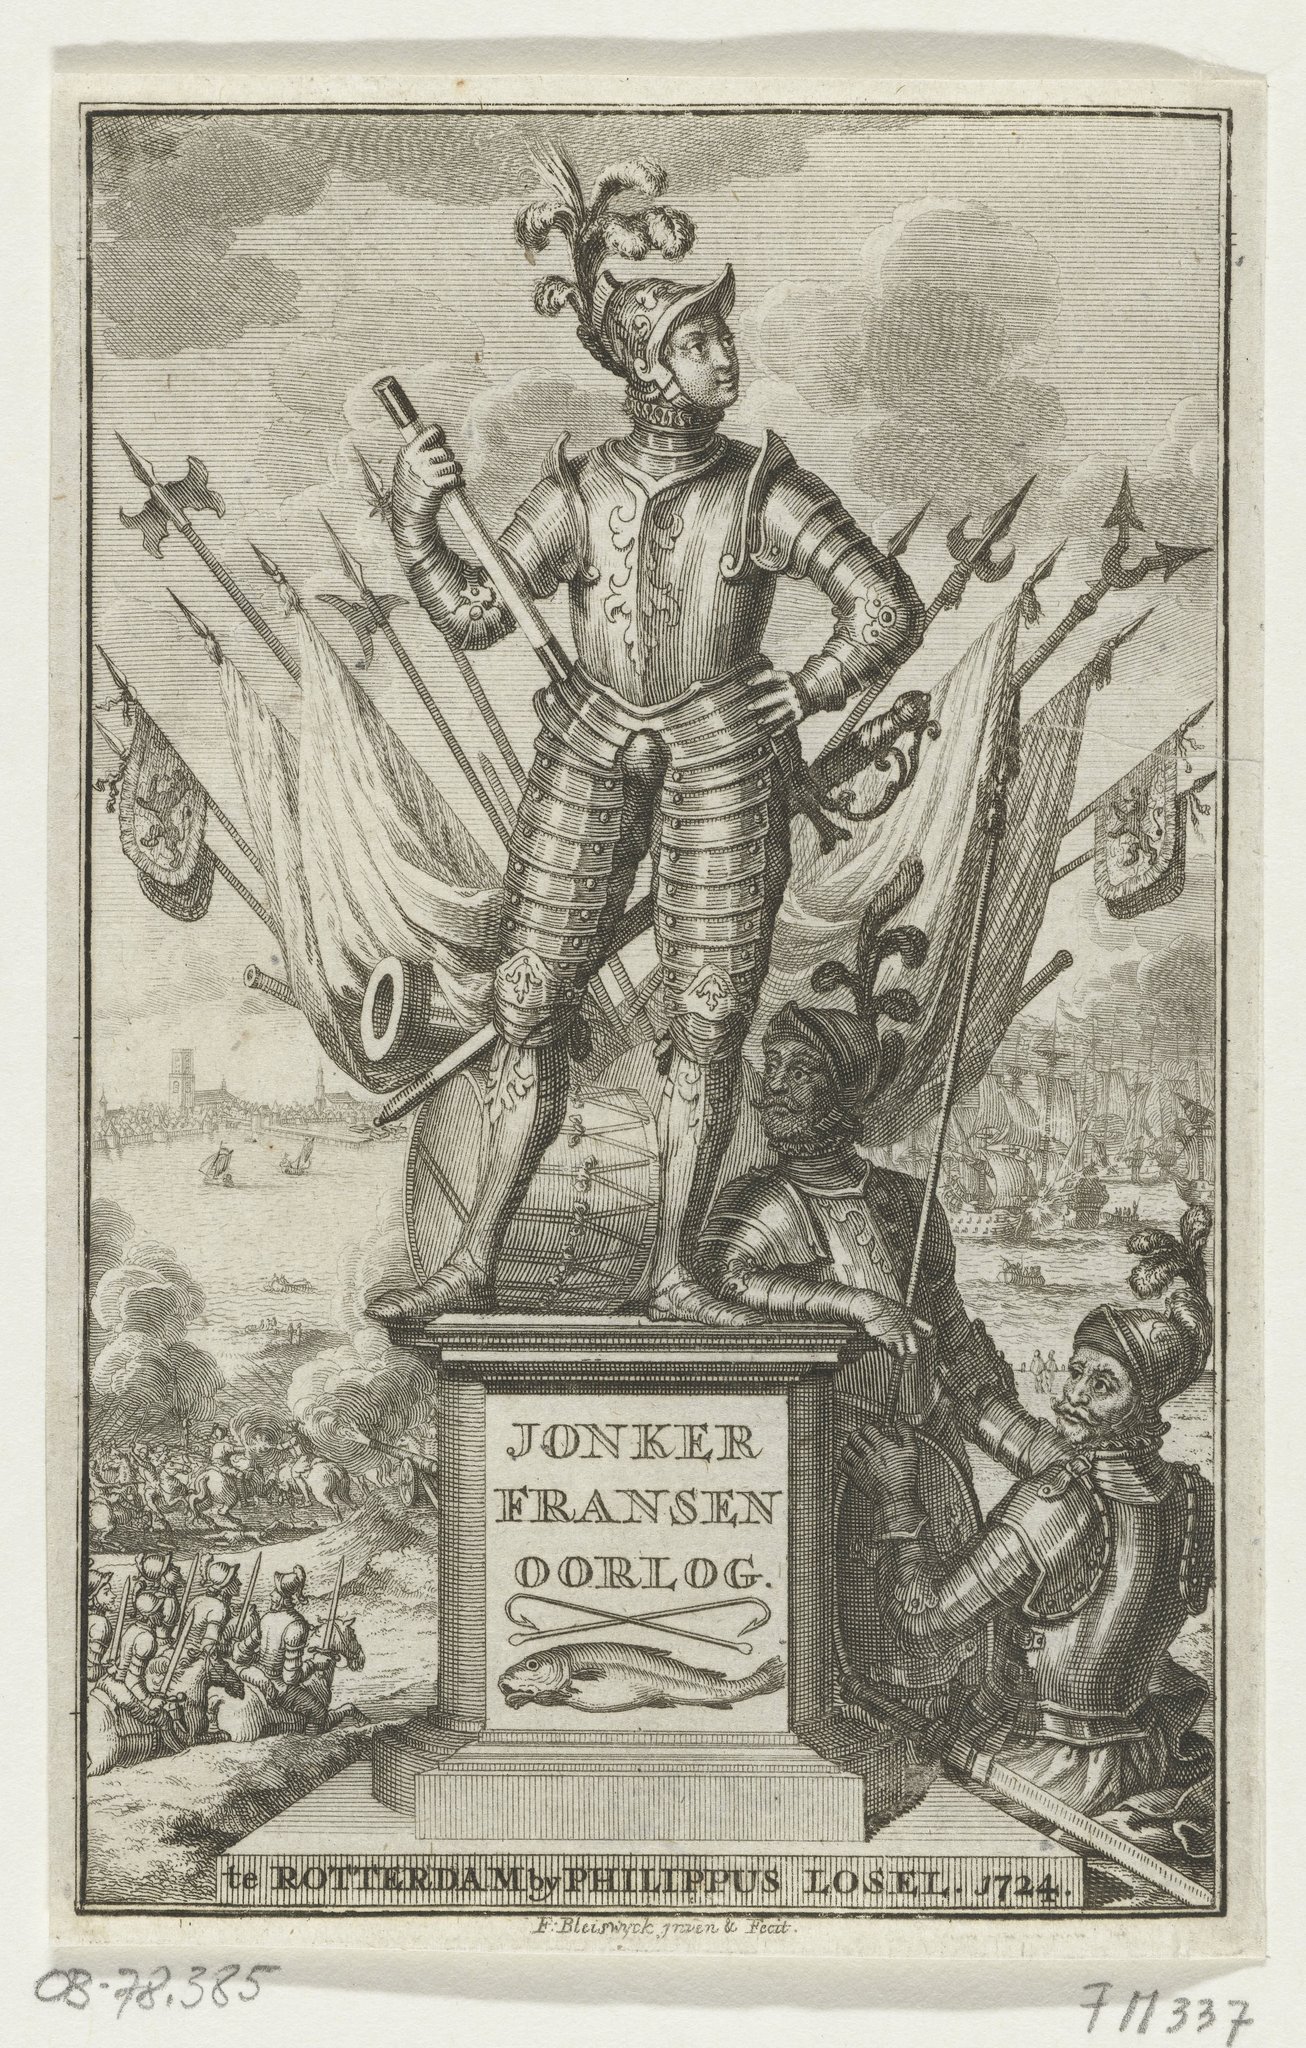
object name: titelprent, frontispice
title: Jonker Fransen oorlog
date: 1724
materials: paper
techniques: etching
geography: rotterdam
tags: rotterdam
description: Illustratie voor: C. van Alkemade, Rotterdamse heldendaden onder de stadvoogdy van (...) Frans van Brederode, genaamt jonker Fransen oorlog, P. Losel, Rotterdam 1724.